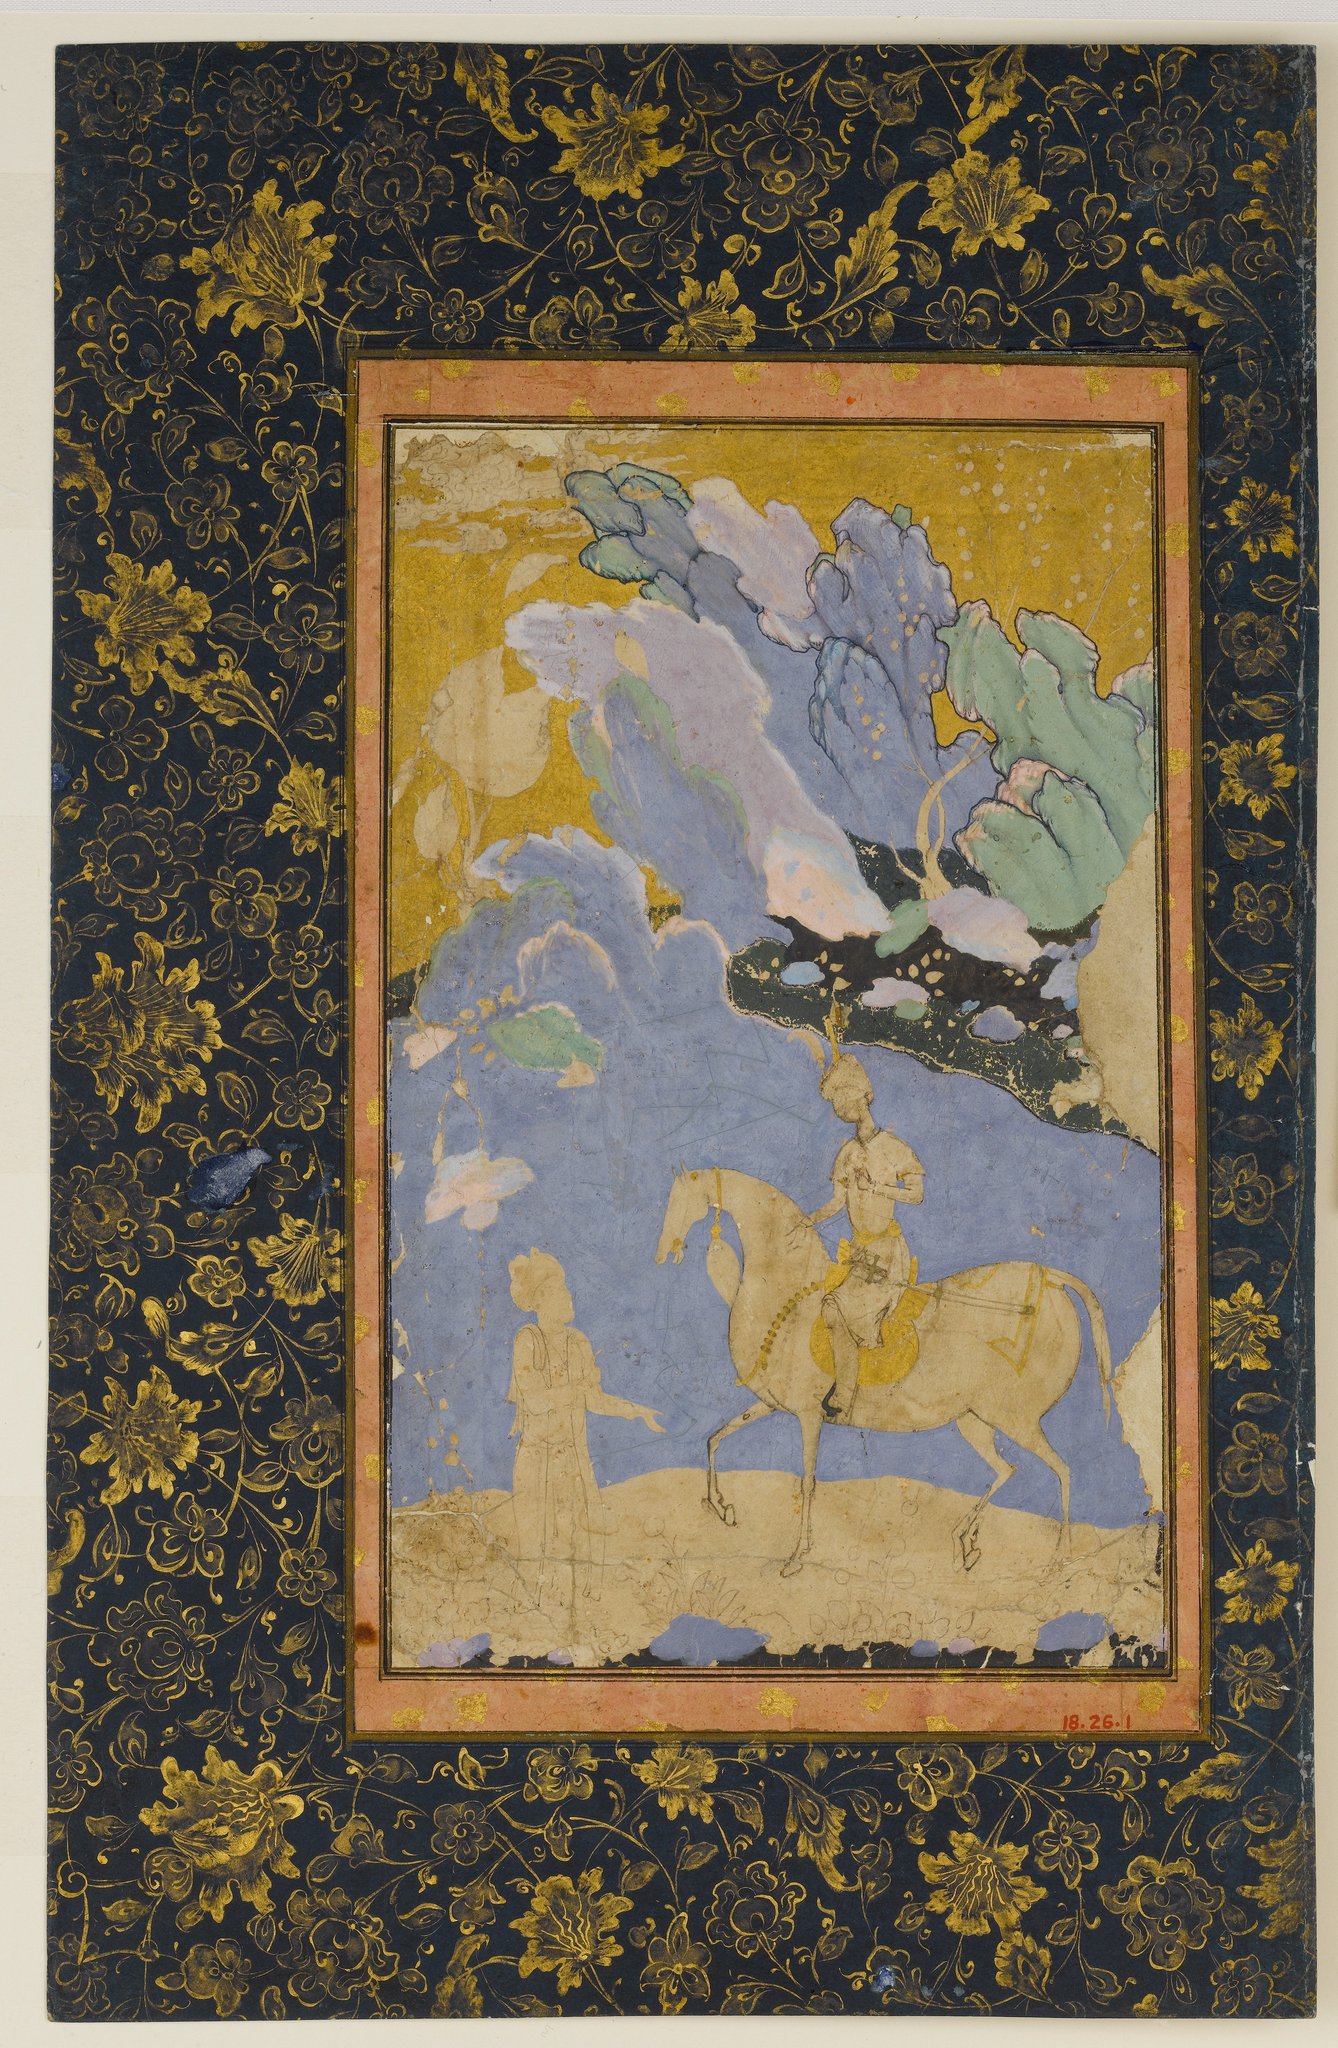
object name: illustrated single work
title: Meeting of a Prince and Poet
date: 1534-1566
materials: gold, ink, paper, silver, watercolor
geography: iran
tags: princes,horses,landscapes,poets